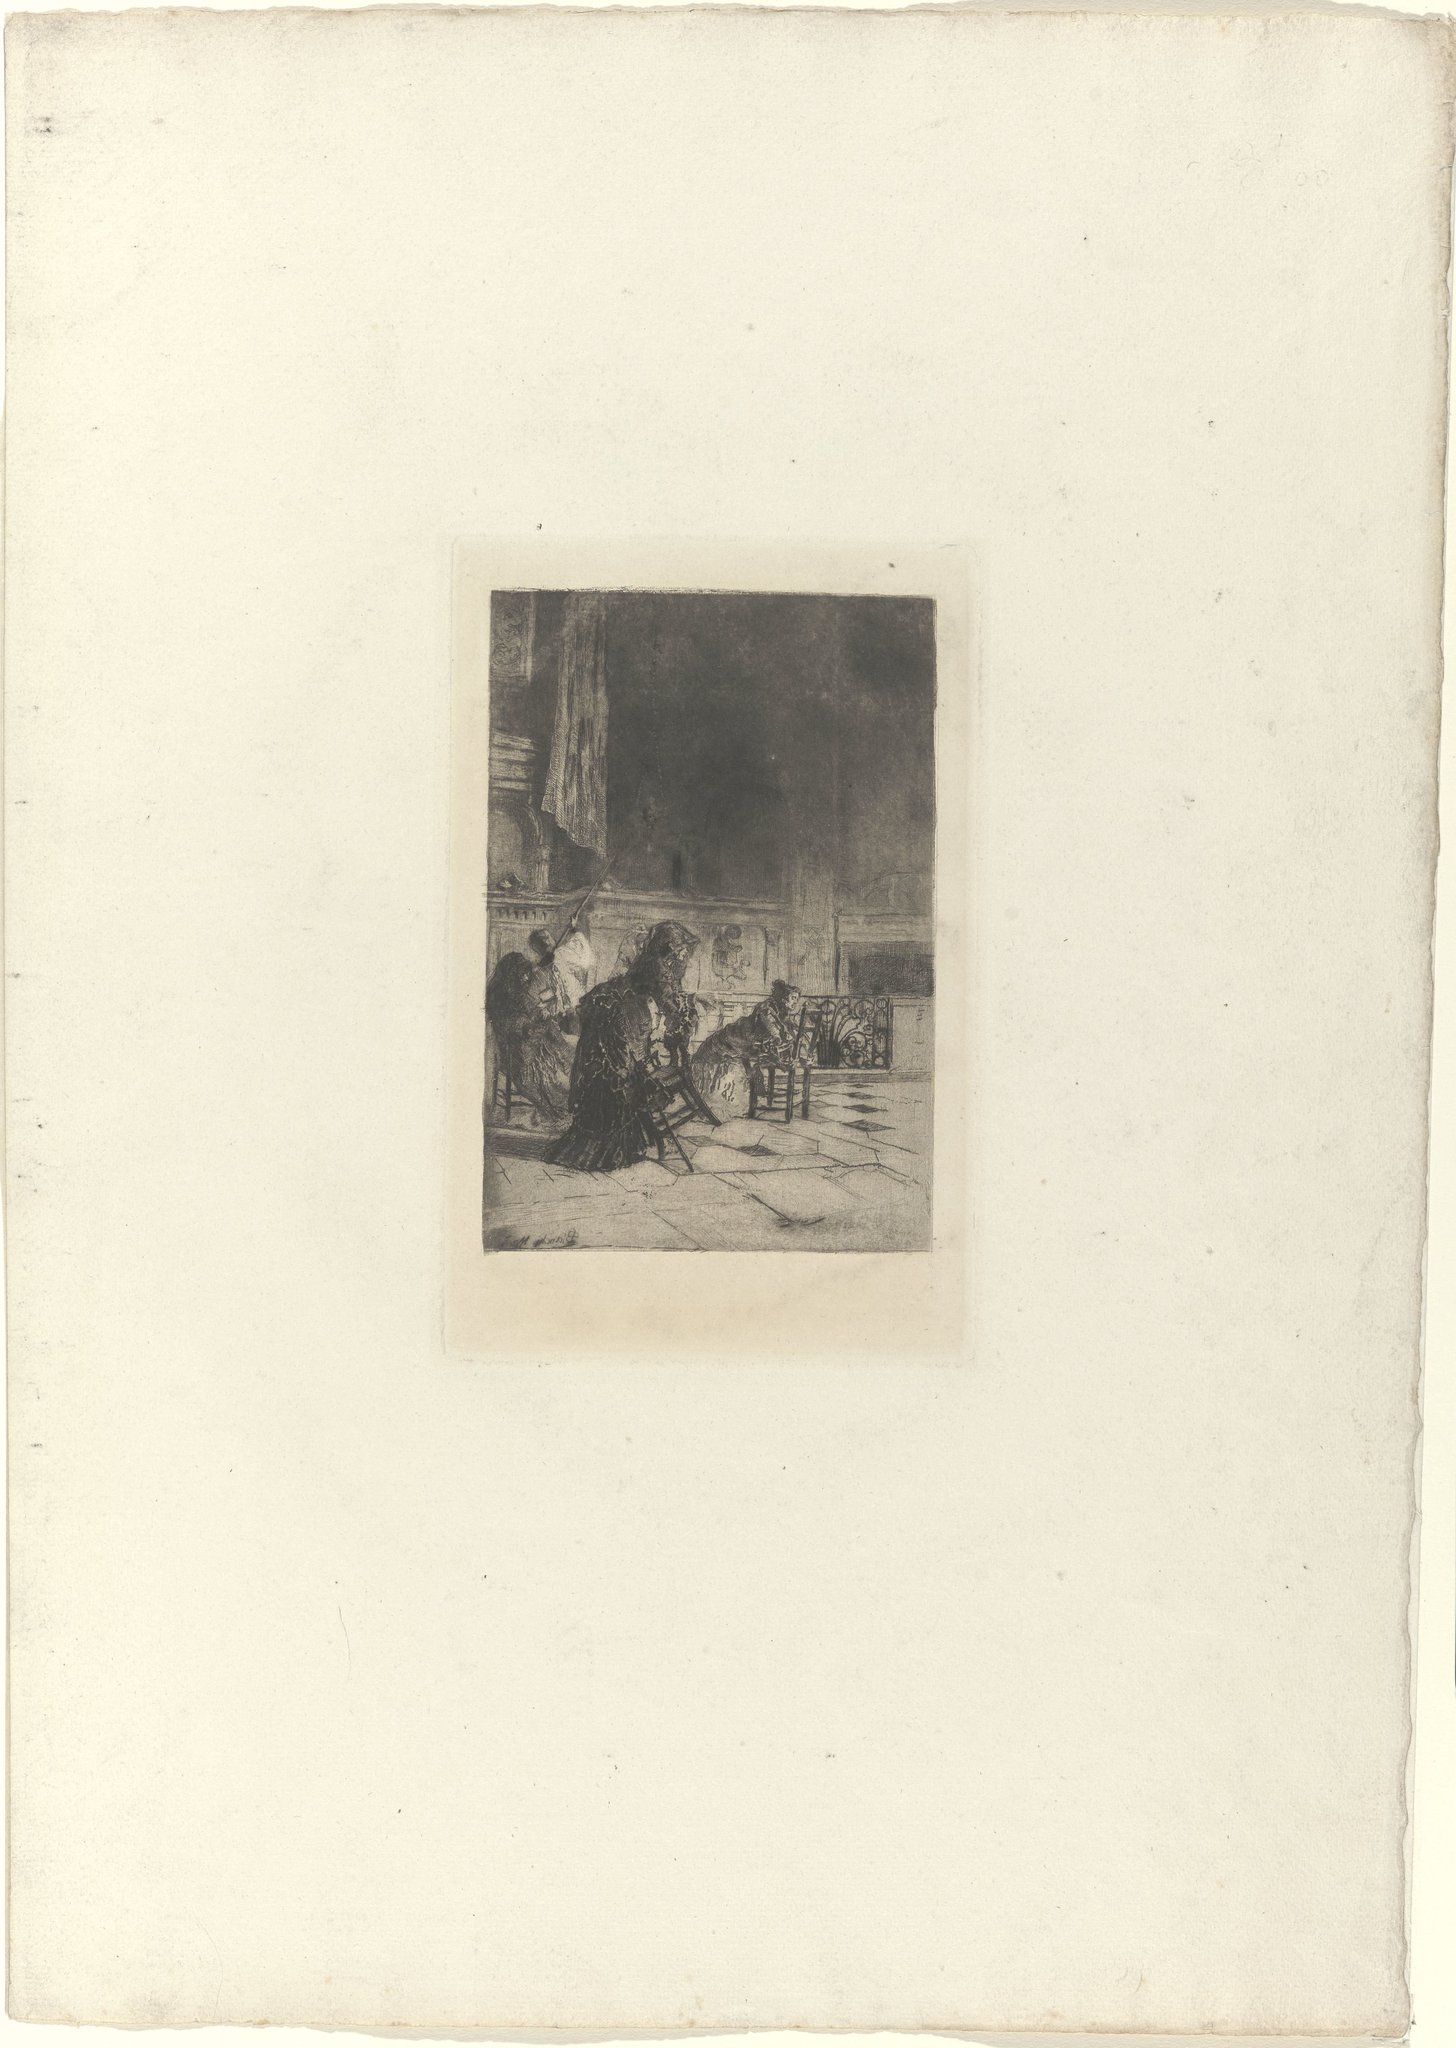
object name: print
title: Biddende mensen in kerk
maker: mosè di giosuè bianchi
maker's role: draughtsman, print maker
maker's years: 1845-1904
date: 1855-1904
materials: paper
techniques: aquatint, drypoint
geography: italy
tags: acolyte, chorister, lector, ostiarius, etc. ~ functionaries in roman catholic church, (private) prayer; 'oratione', 'preghiere', 'preghiere a dio' (ripa), interior of church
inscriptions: collector's mark: Lugt 2228, collector's mark: Lugt 2760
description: Interieur van een kerk met biddende mensen. Op de achtergrond links een misdienaar die een wierookvat dooft of aansteekt.